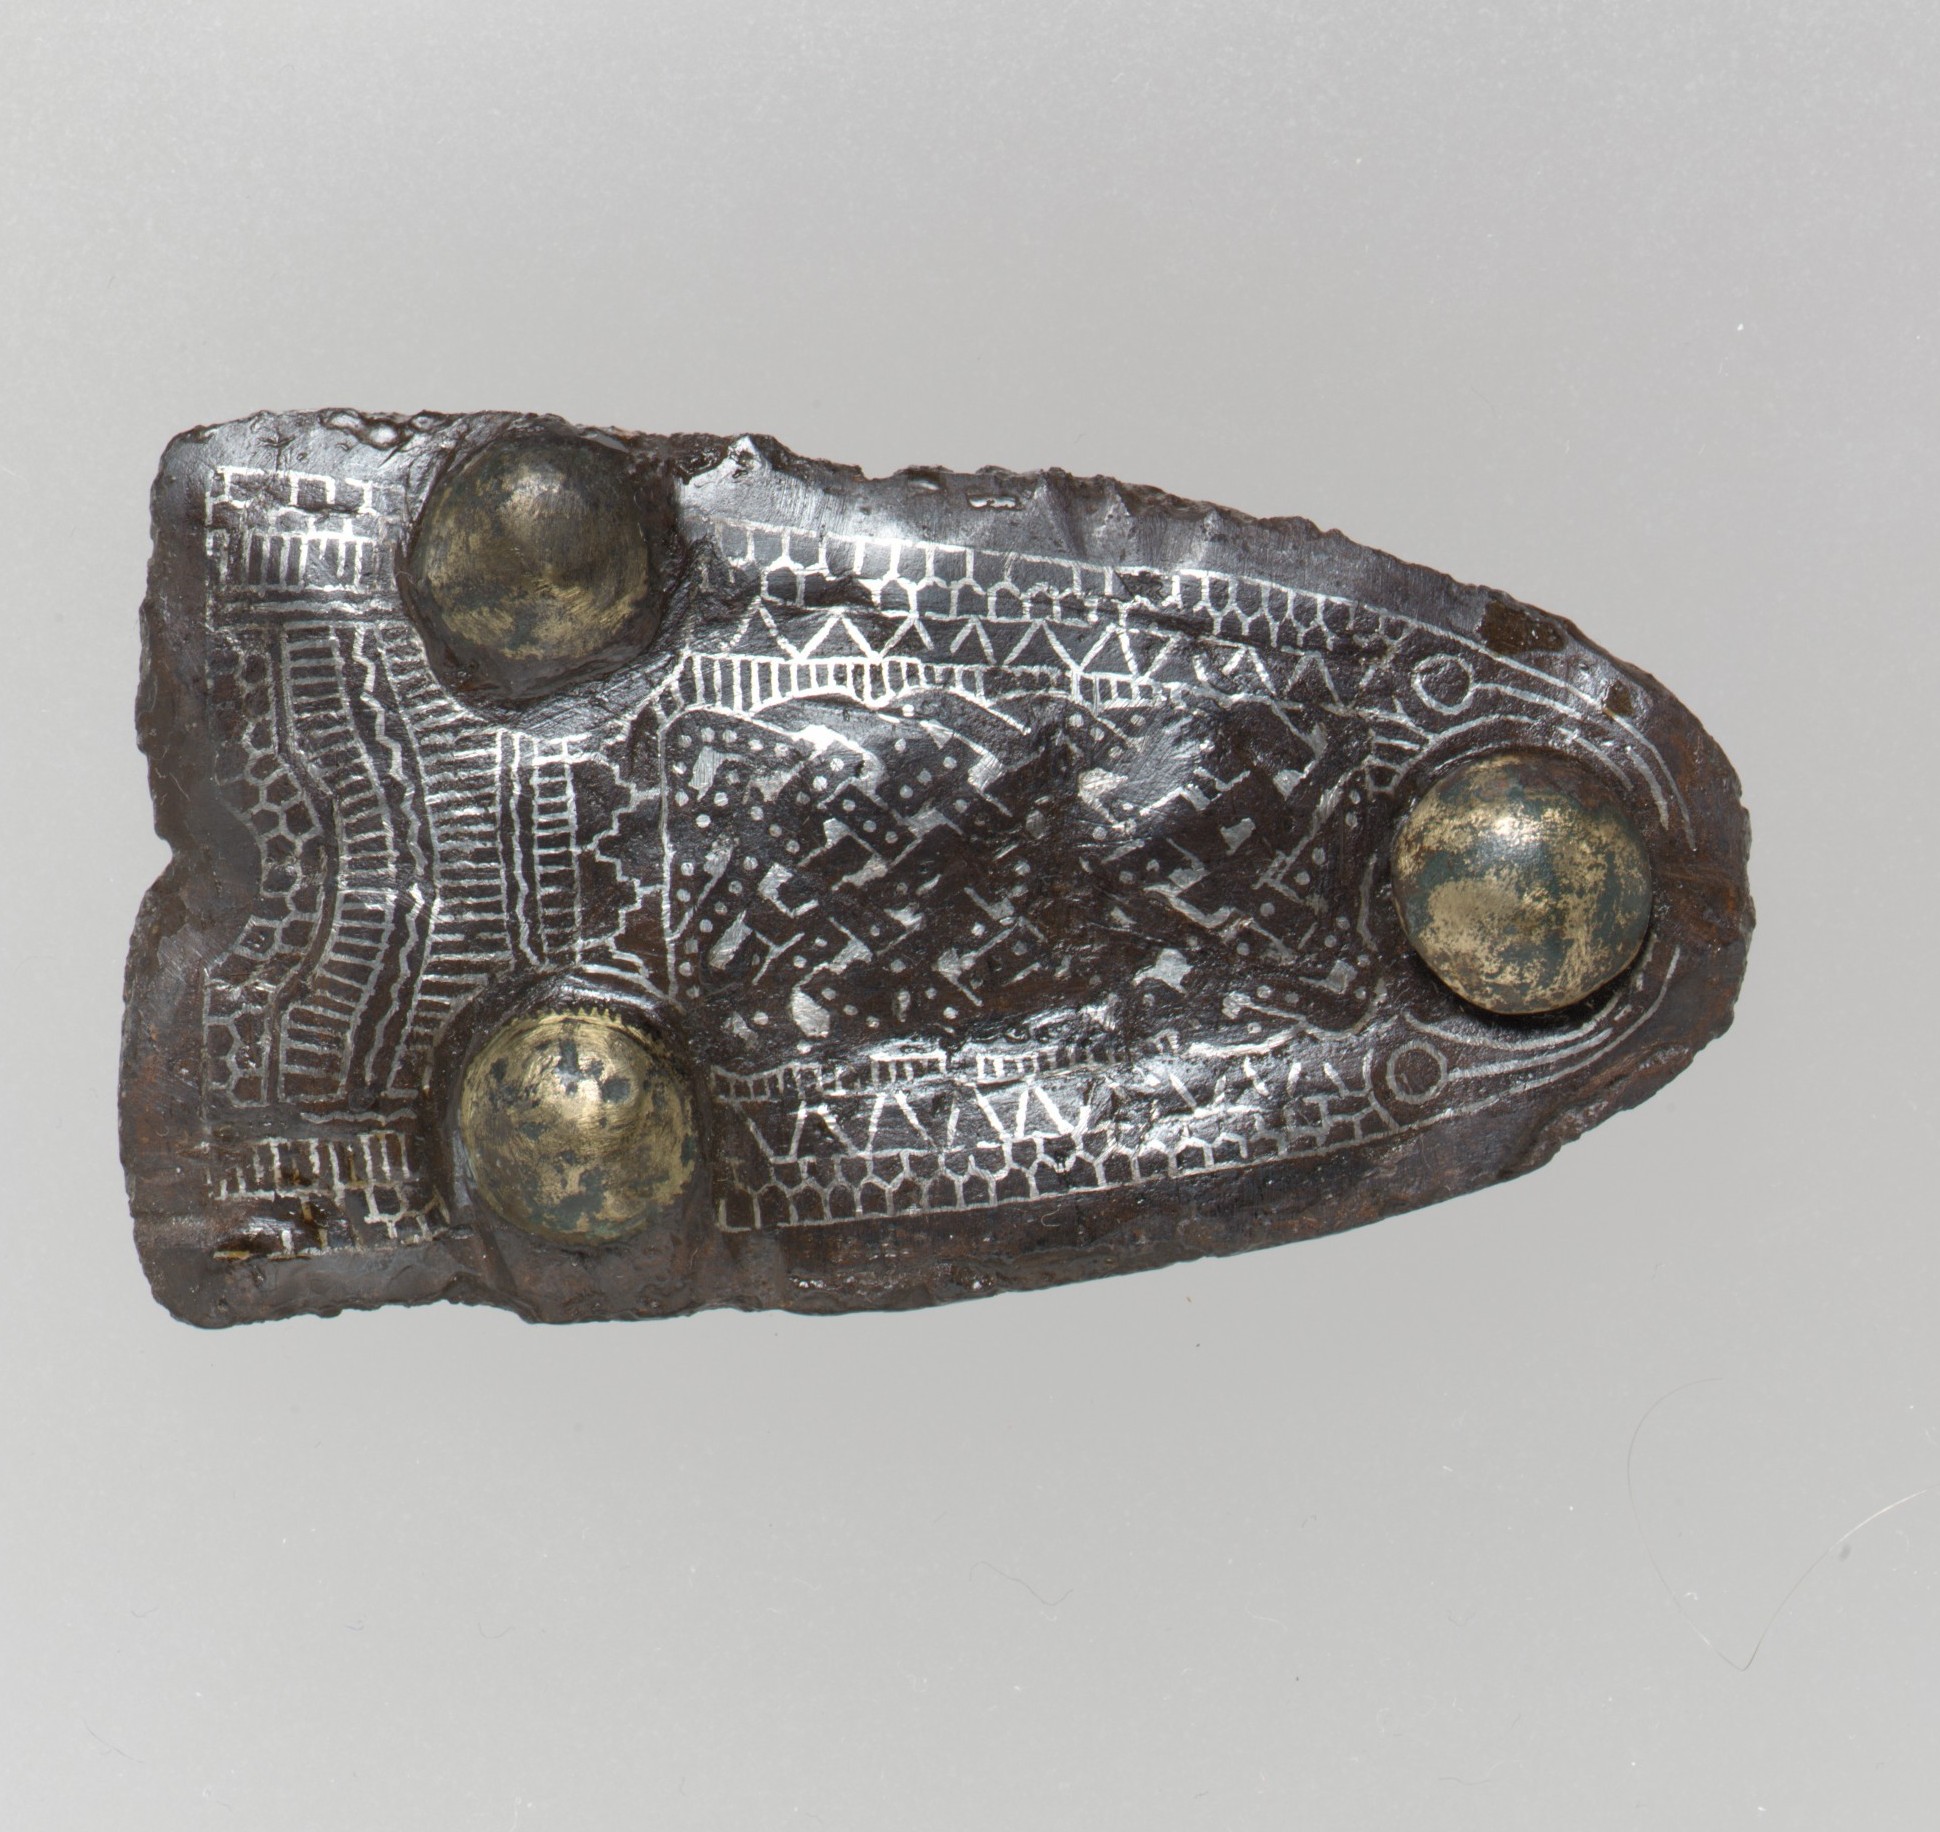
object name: belt plate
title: Counter Plate of a Belt Buckle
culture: frankish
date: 567-633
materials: iron, silver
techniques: inlay